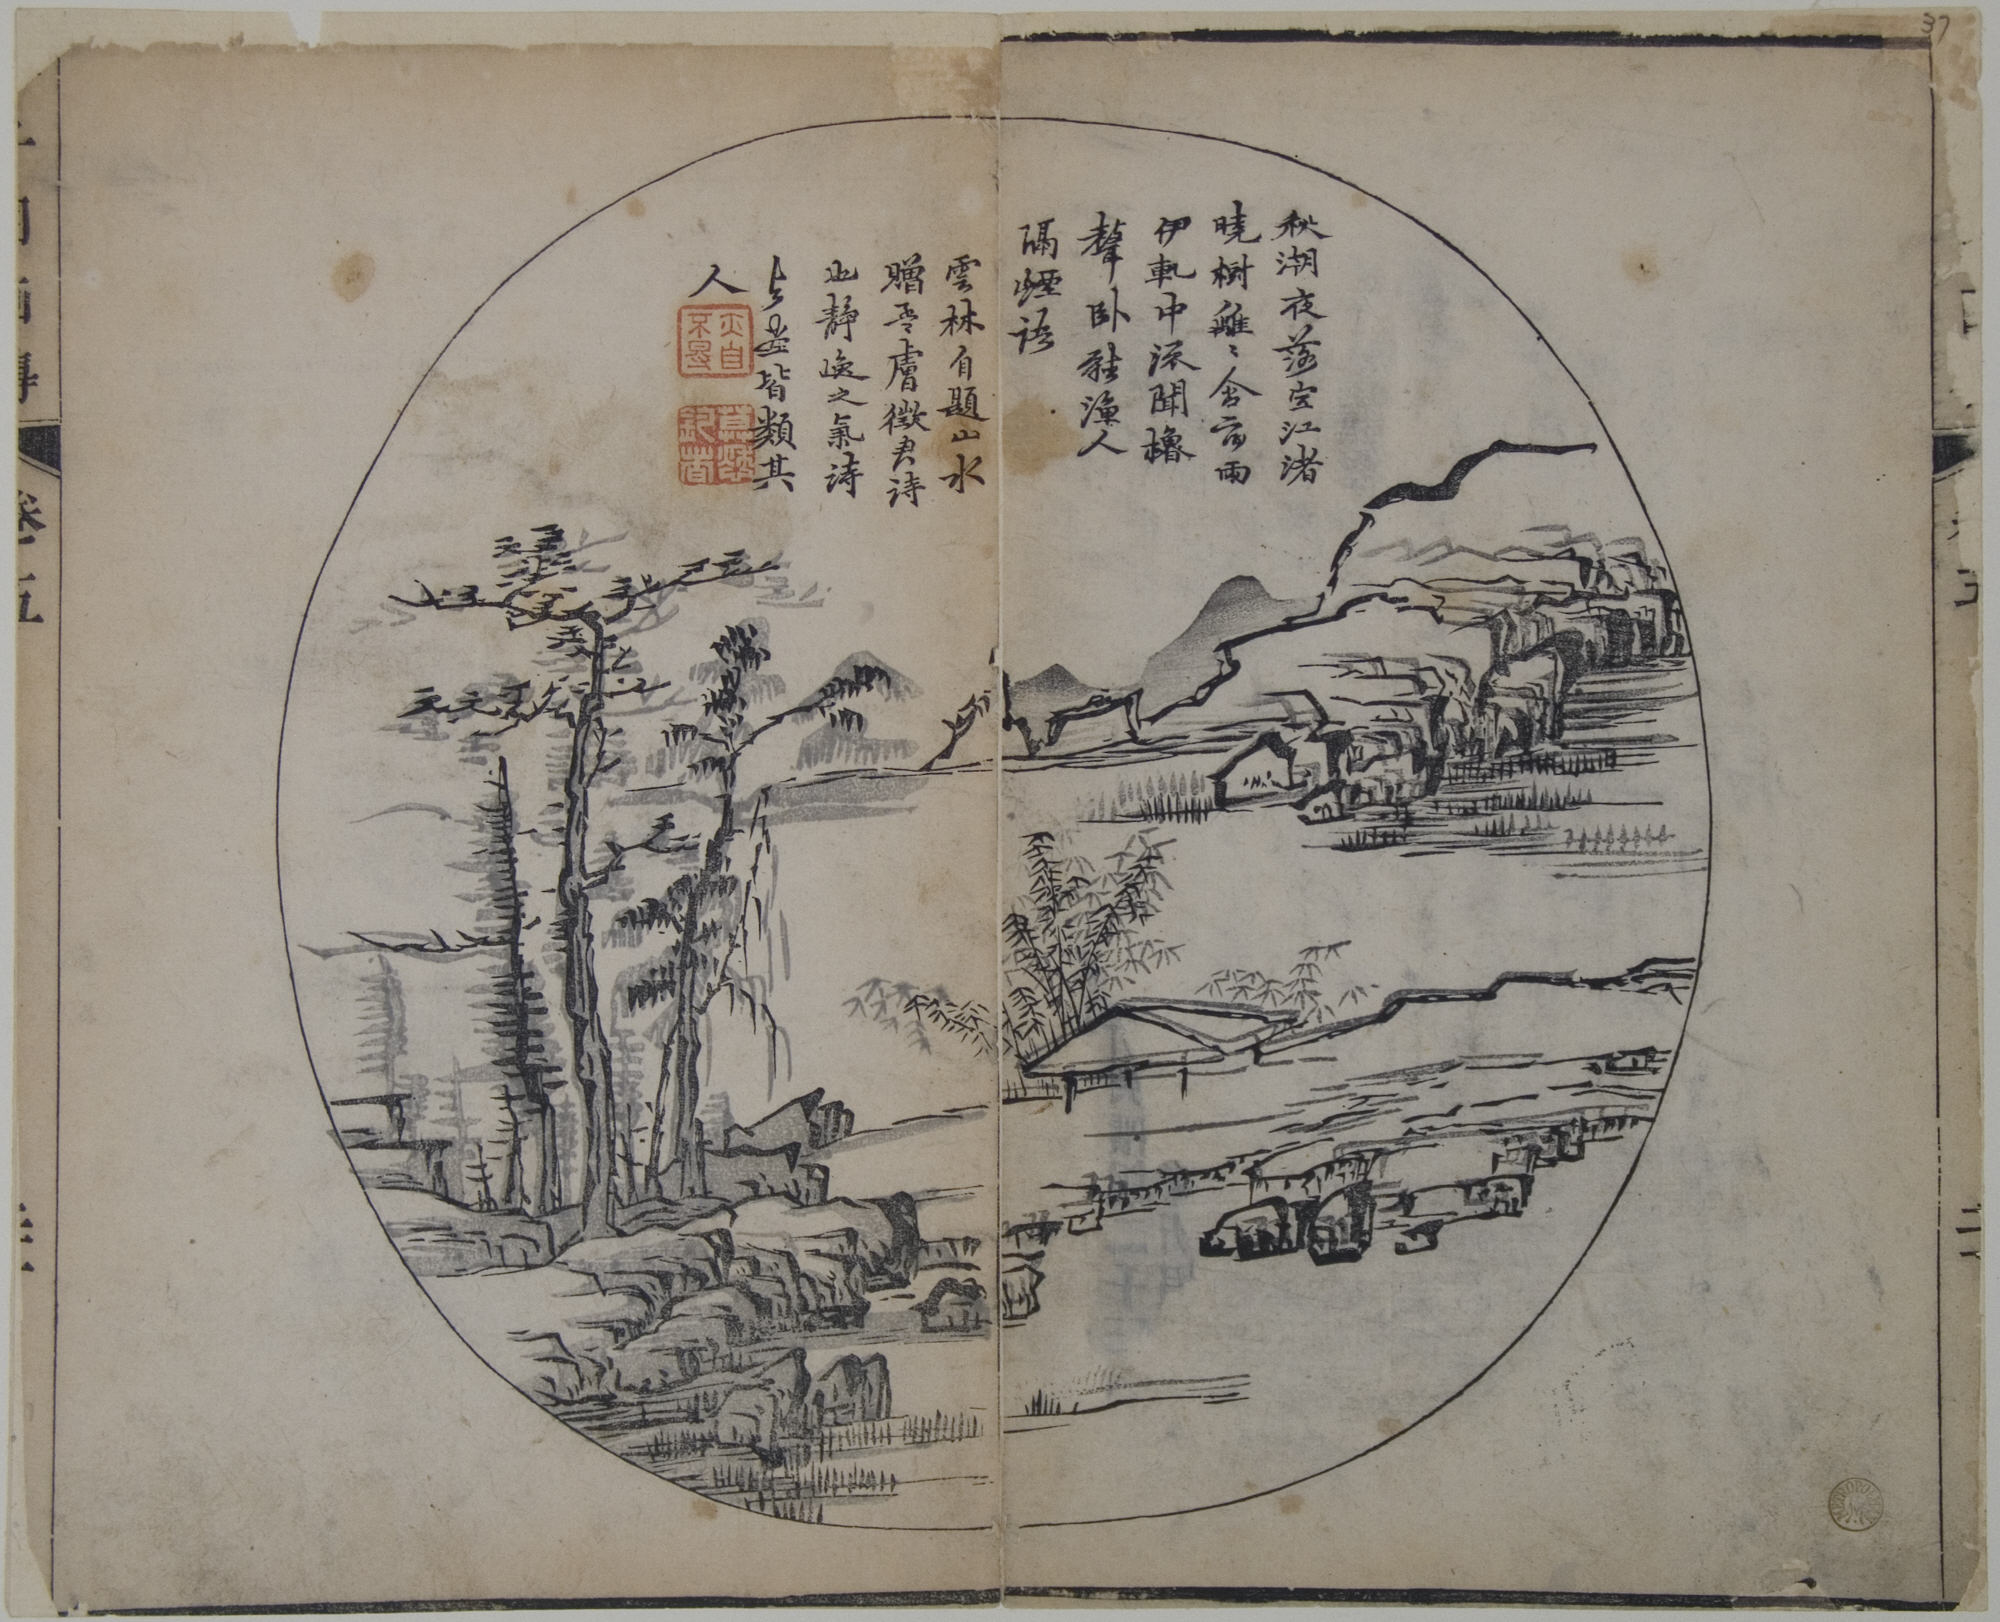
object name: print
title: Page from the Mustard Seed Garden Manual of Painting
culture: chinese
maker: wang gai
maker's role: artist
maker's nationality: chinese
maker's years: 1645-1710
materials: ink, paper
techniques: woodblock print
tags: hills,trees